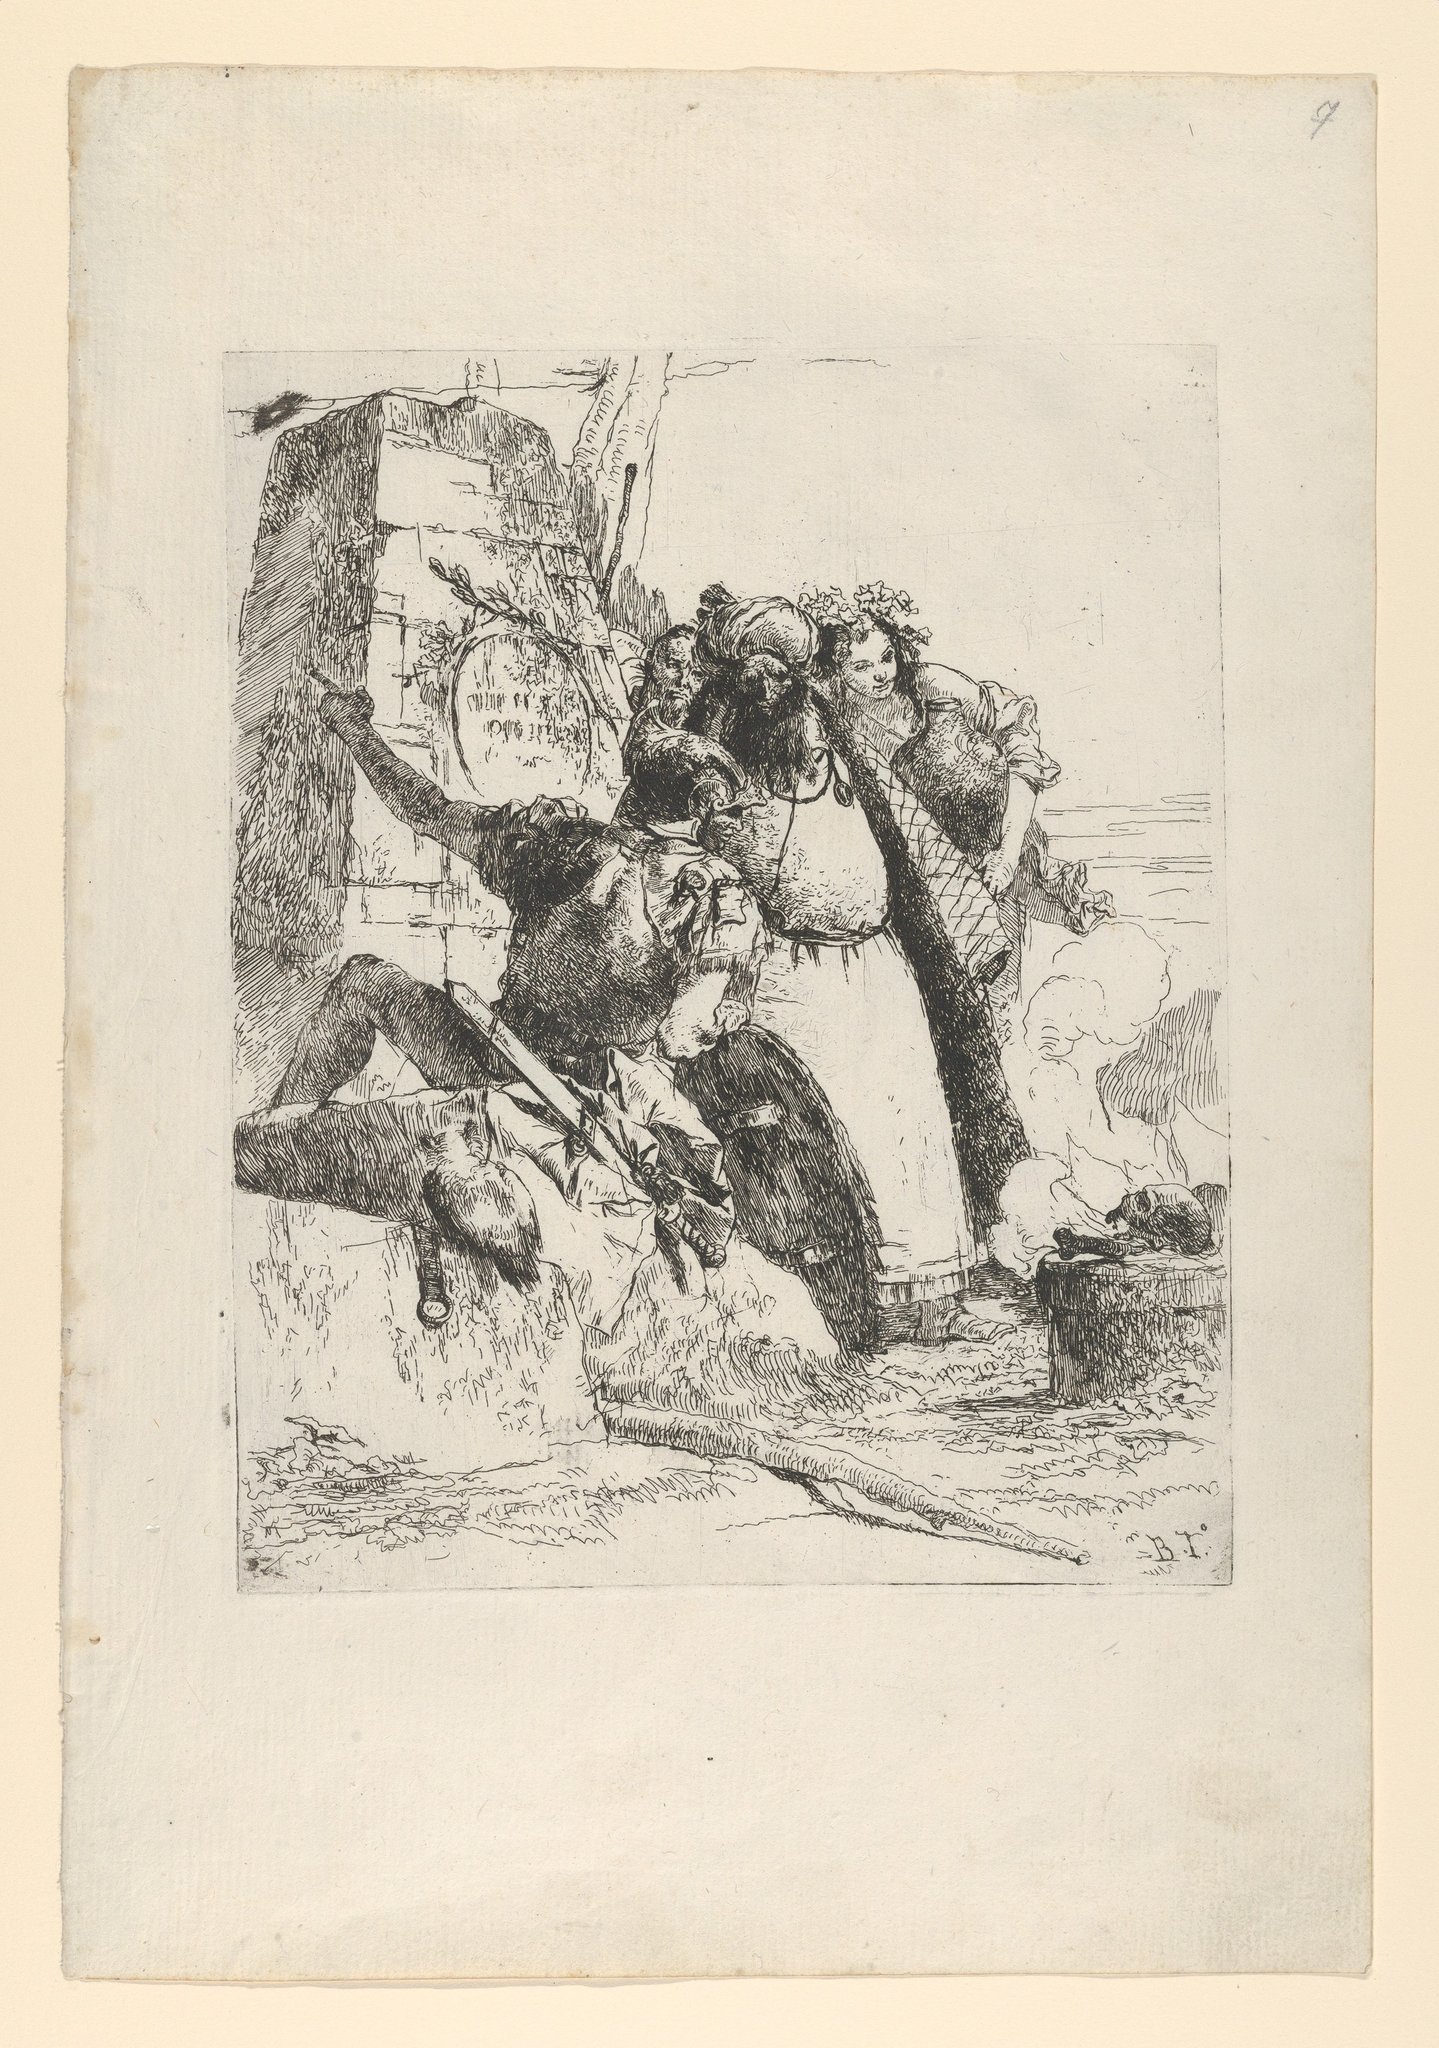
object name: print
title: A magician, a soldier and three figures watching a burning skull from the Scherzi di Fantasia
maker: giovanni battista tiepolo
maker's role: artist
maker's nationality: italian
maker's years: 1696-1770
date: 1743-1750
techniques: etching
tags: soldiers,skulls,men,women,magicians